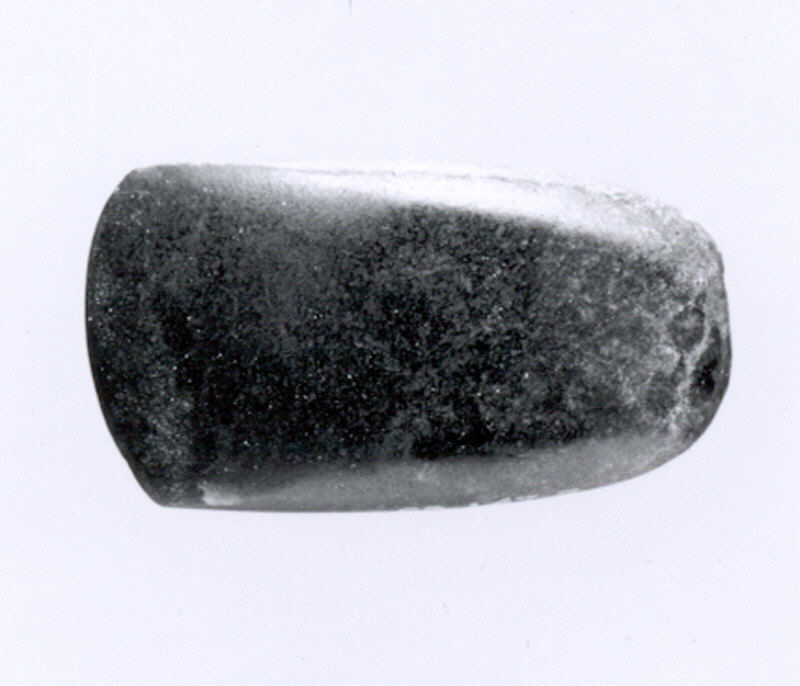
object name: axe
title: Axe head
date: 3000-2001 BCE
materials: stone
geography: anatolia